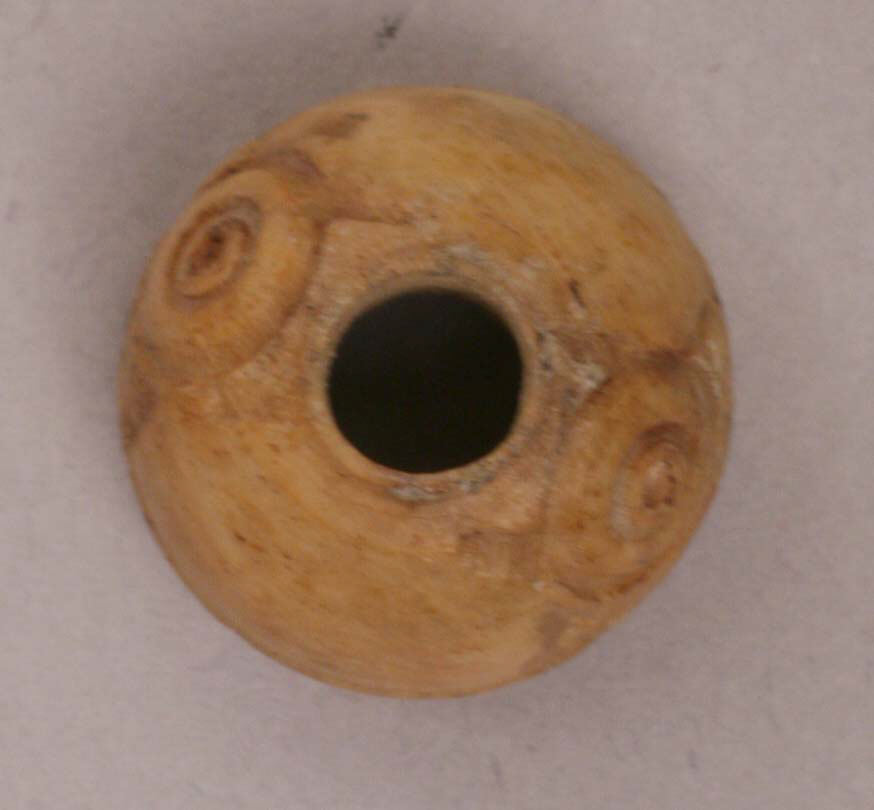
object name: button or bead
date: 801-1000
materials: bone, paint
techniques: incising, inlay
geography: iran